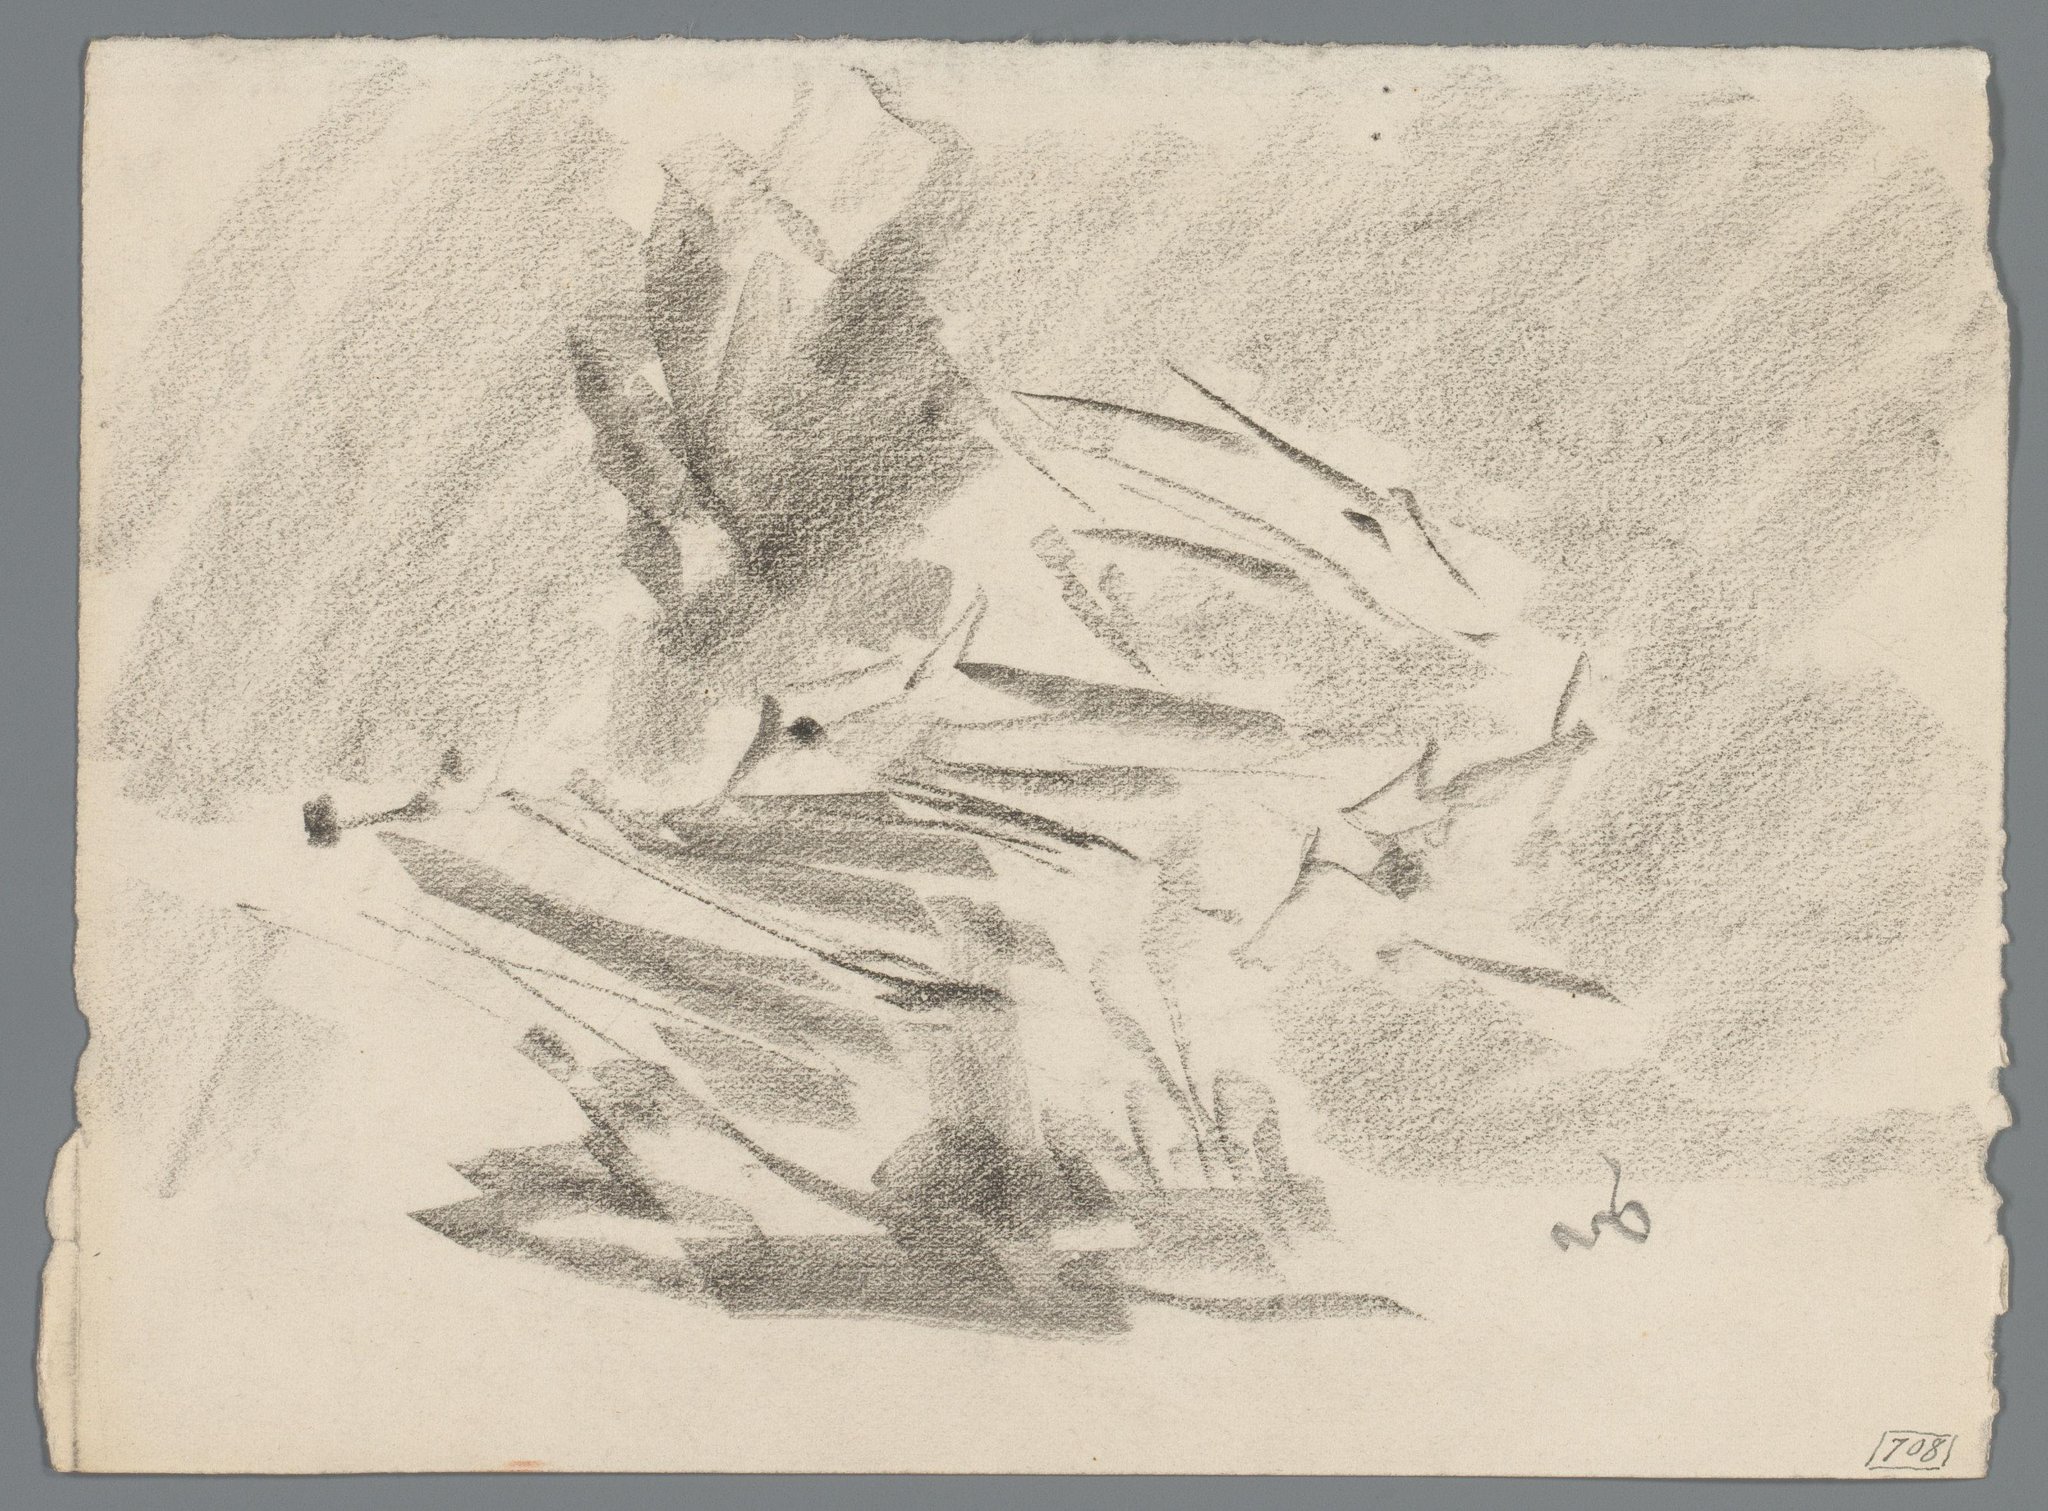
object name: drawing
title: Studie van een aquarium met vissen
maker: gerrit willem dijsselhof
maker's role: designer, draughtsman, print maker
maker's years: 1866-1924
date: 1876-1924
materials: chalk, paper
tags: aquarium, bony fishes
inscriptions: number: ‘708’